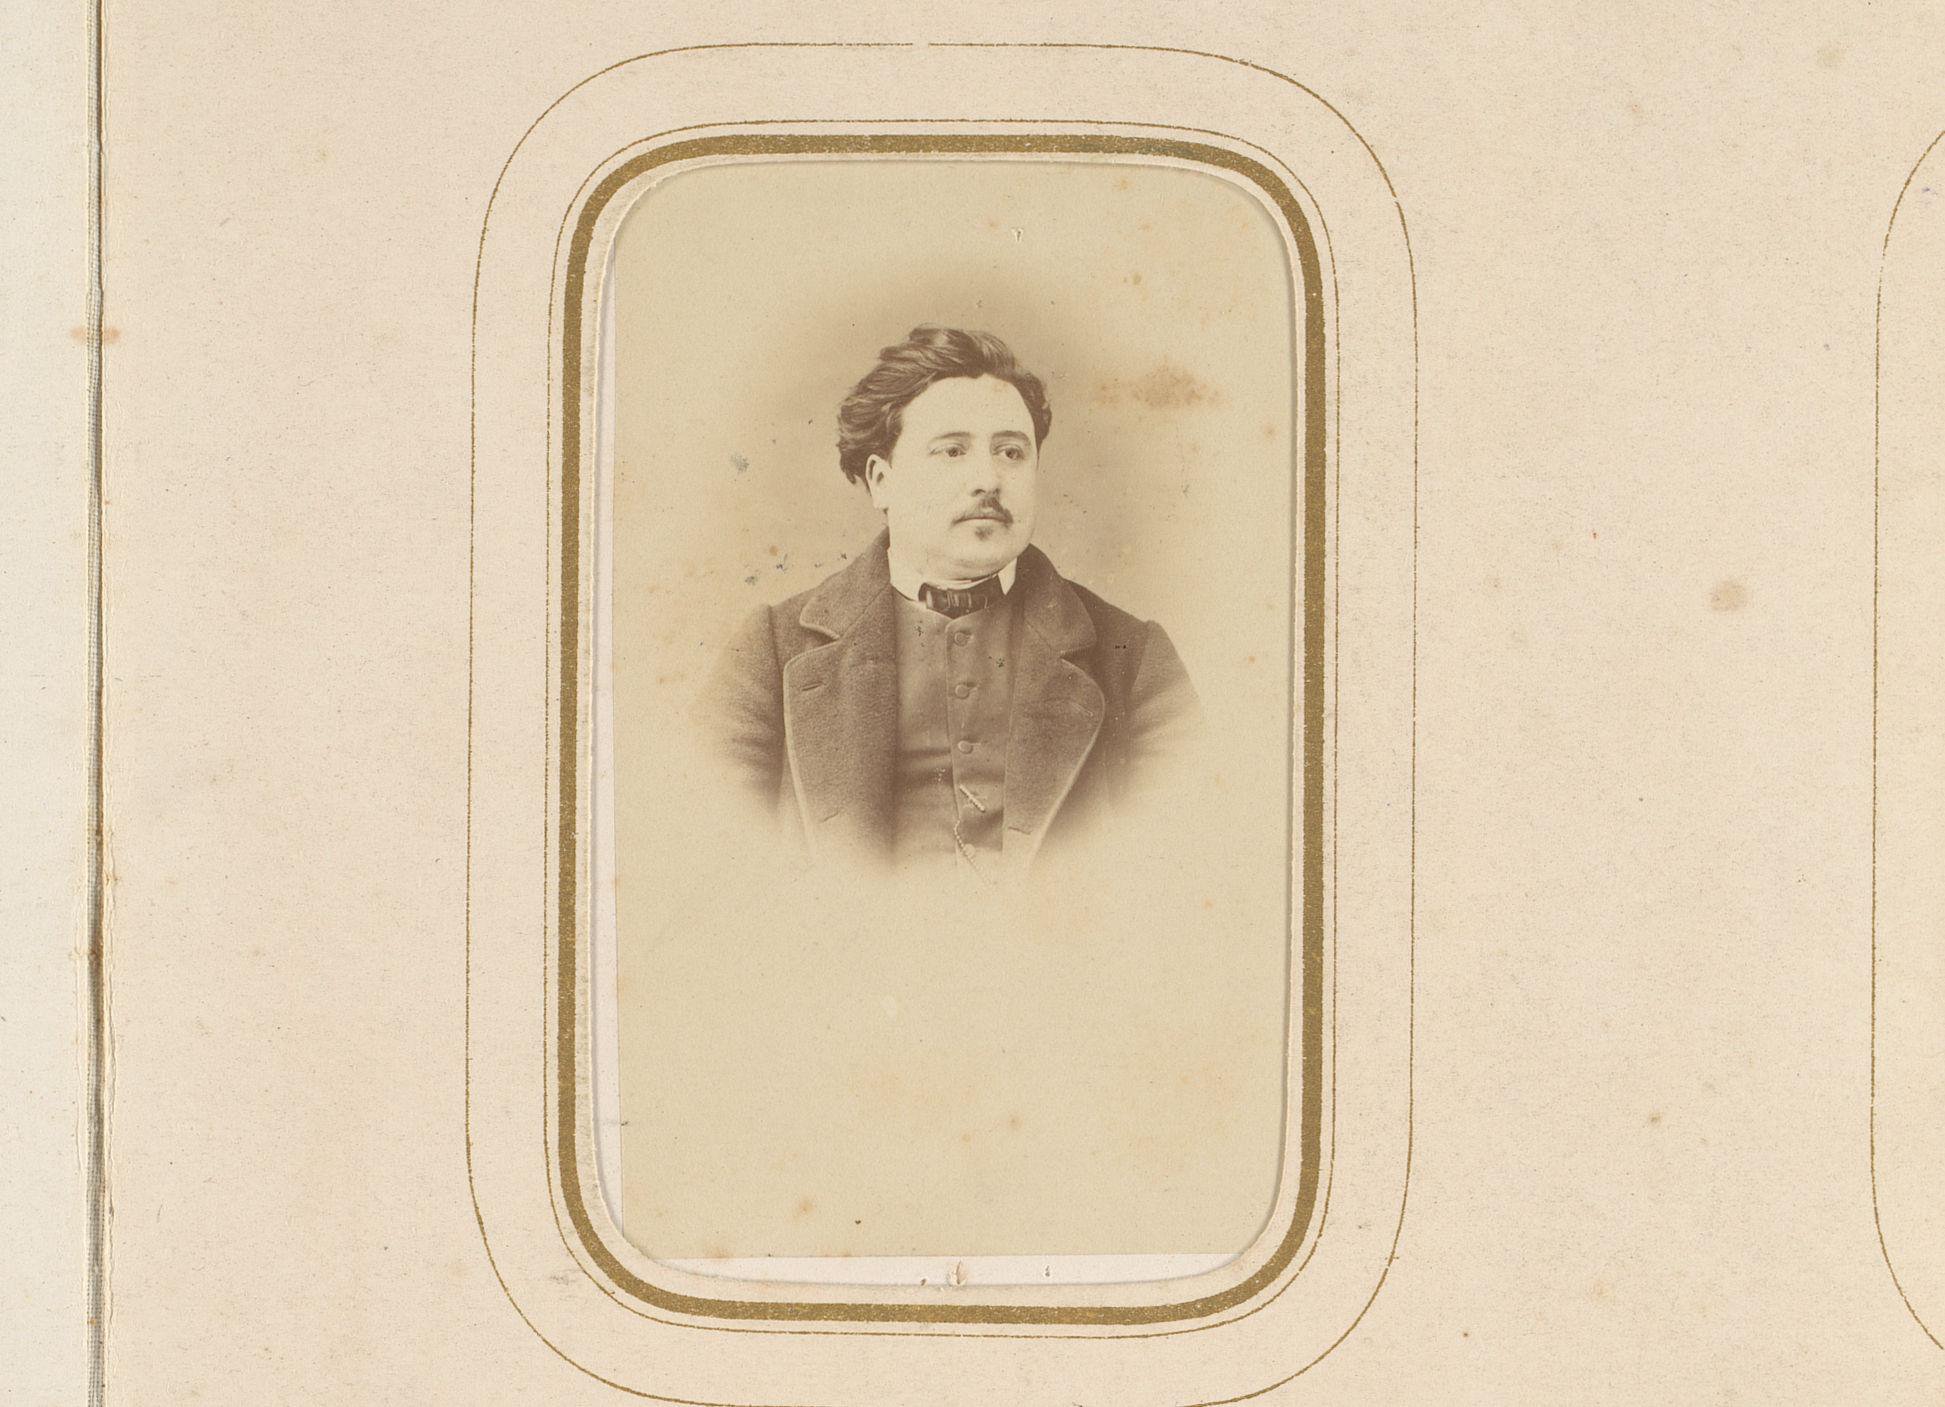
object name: carte de visite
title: Portret van een jongeman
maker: Anonymous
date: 1860-1890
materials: cardboard, photographic support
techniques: albumen print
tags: boy (child between toddler and youth)